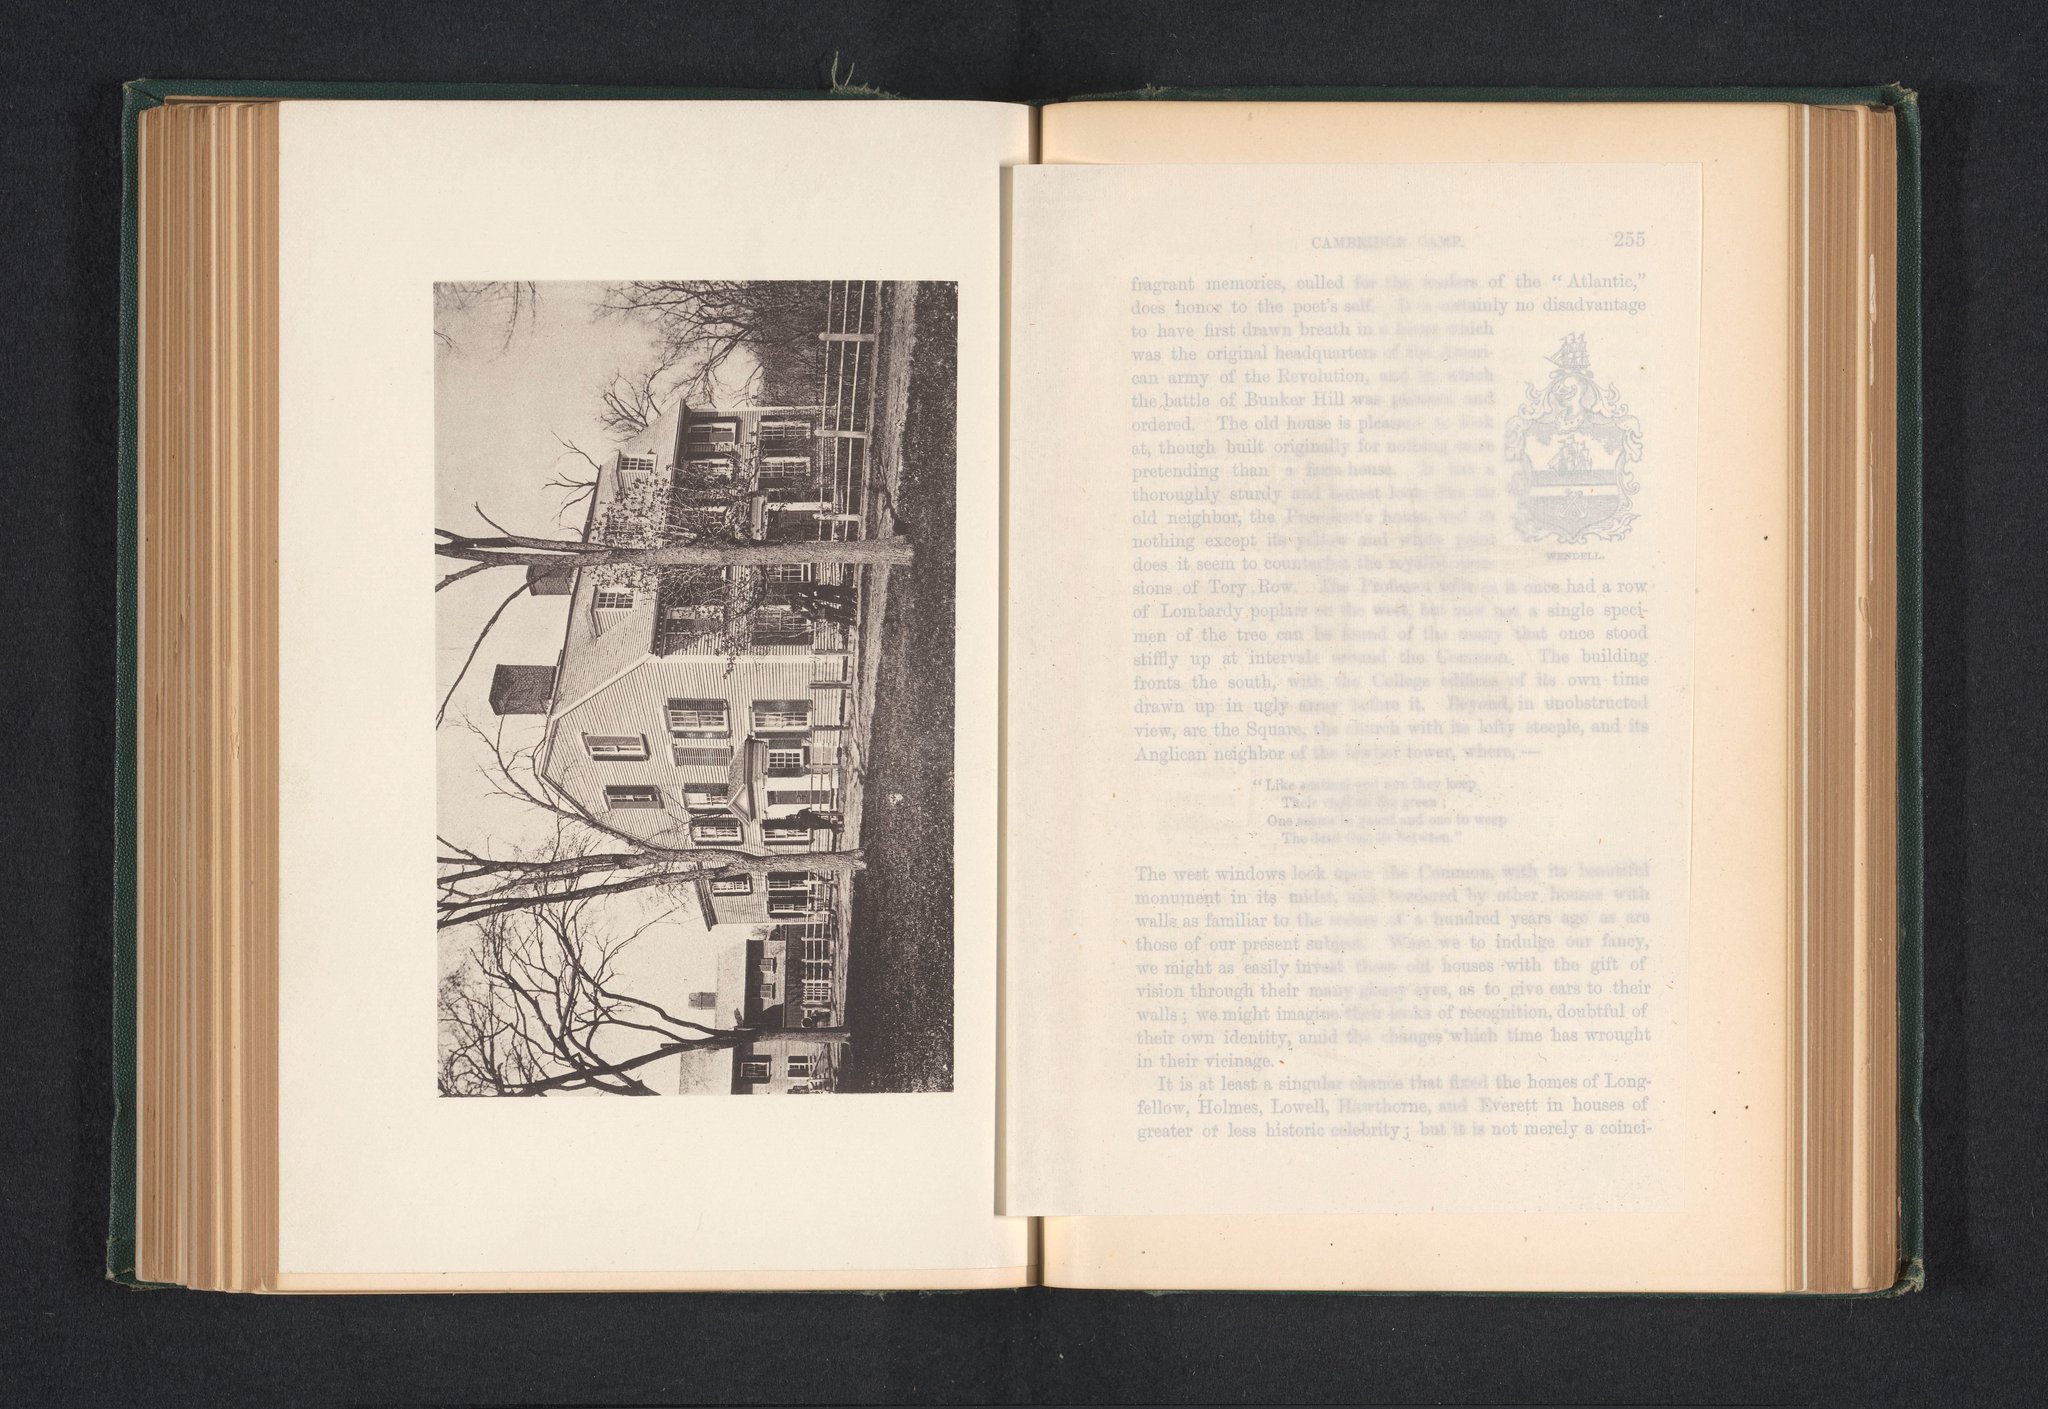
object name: page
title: Gezicht op een provinciaal hoofdkantoor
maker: Anonymous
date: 1869-1874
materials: paper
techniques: photograph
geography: cambridge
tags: provincial government, façade (of house or building)